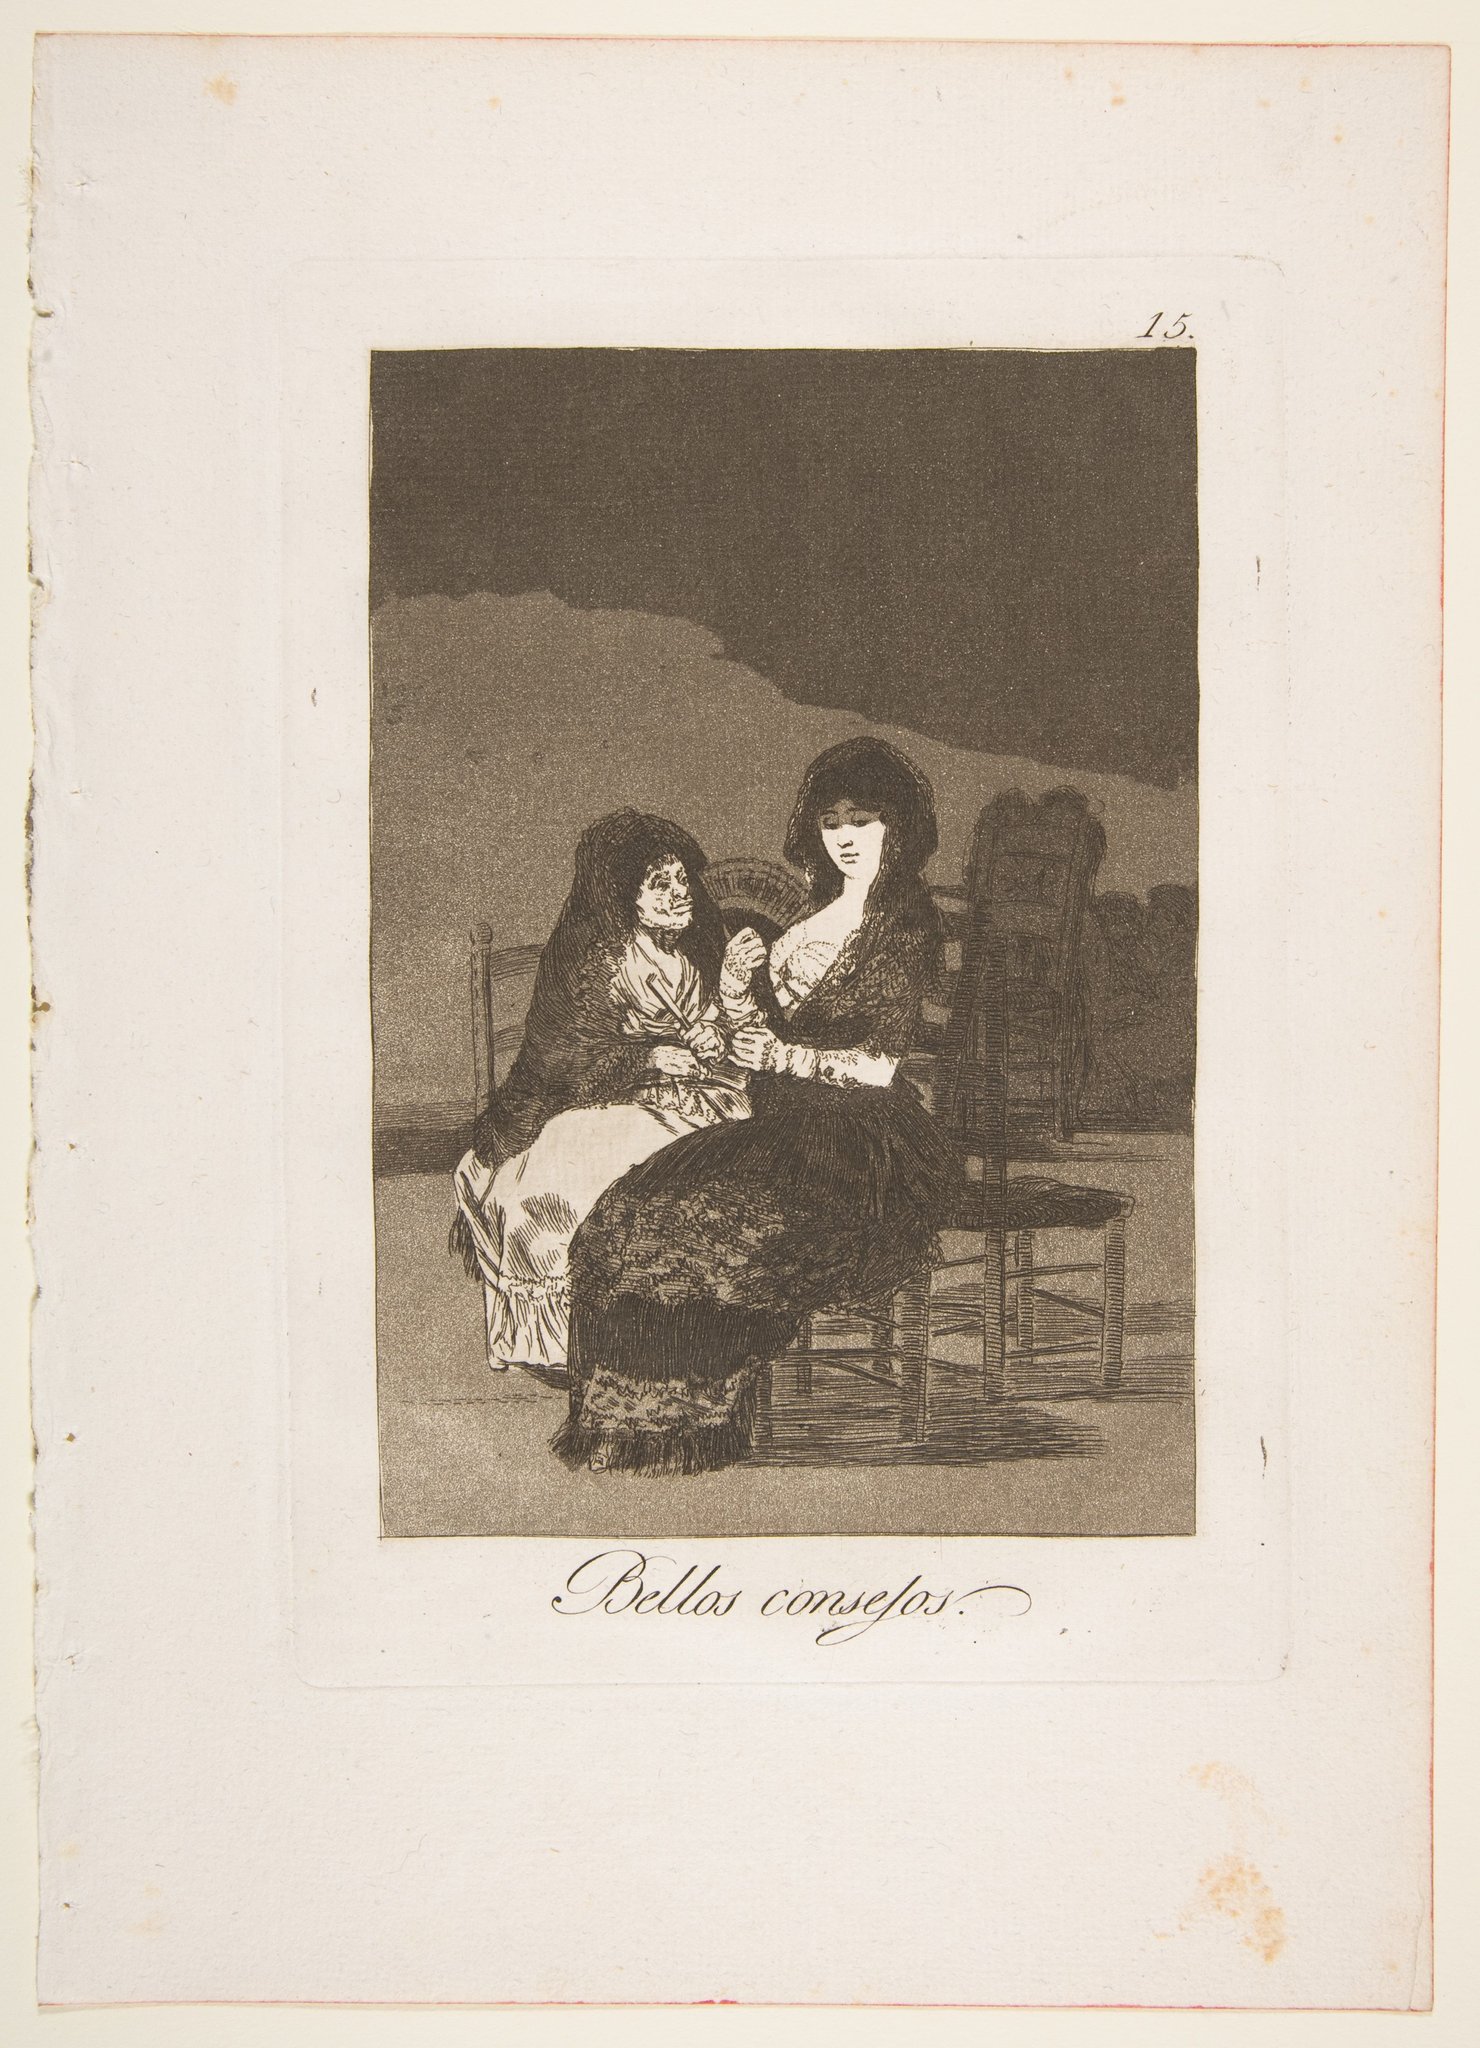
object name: print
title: Plate 15 from "Los Caprichos": A pretty piece of advice (Bellos consejos)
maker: goya (francisco de goya y lucientes)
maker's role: artist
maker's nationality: spanish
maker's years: 1746-1828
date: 1799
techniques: aquatint, engraving, burnishing, etching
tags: women